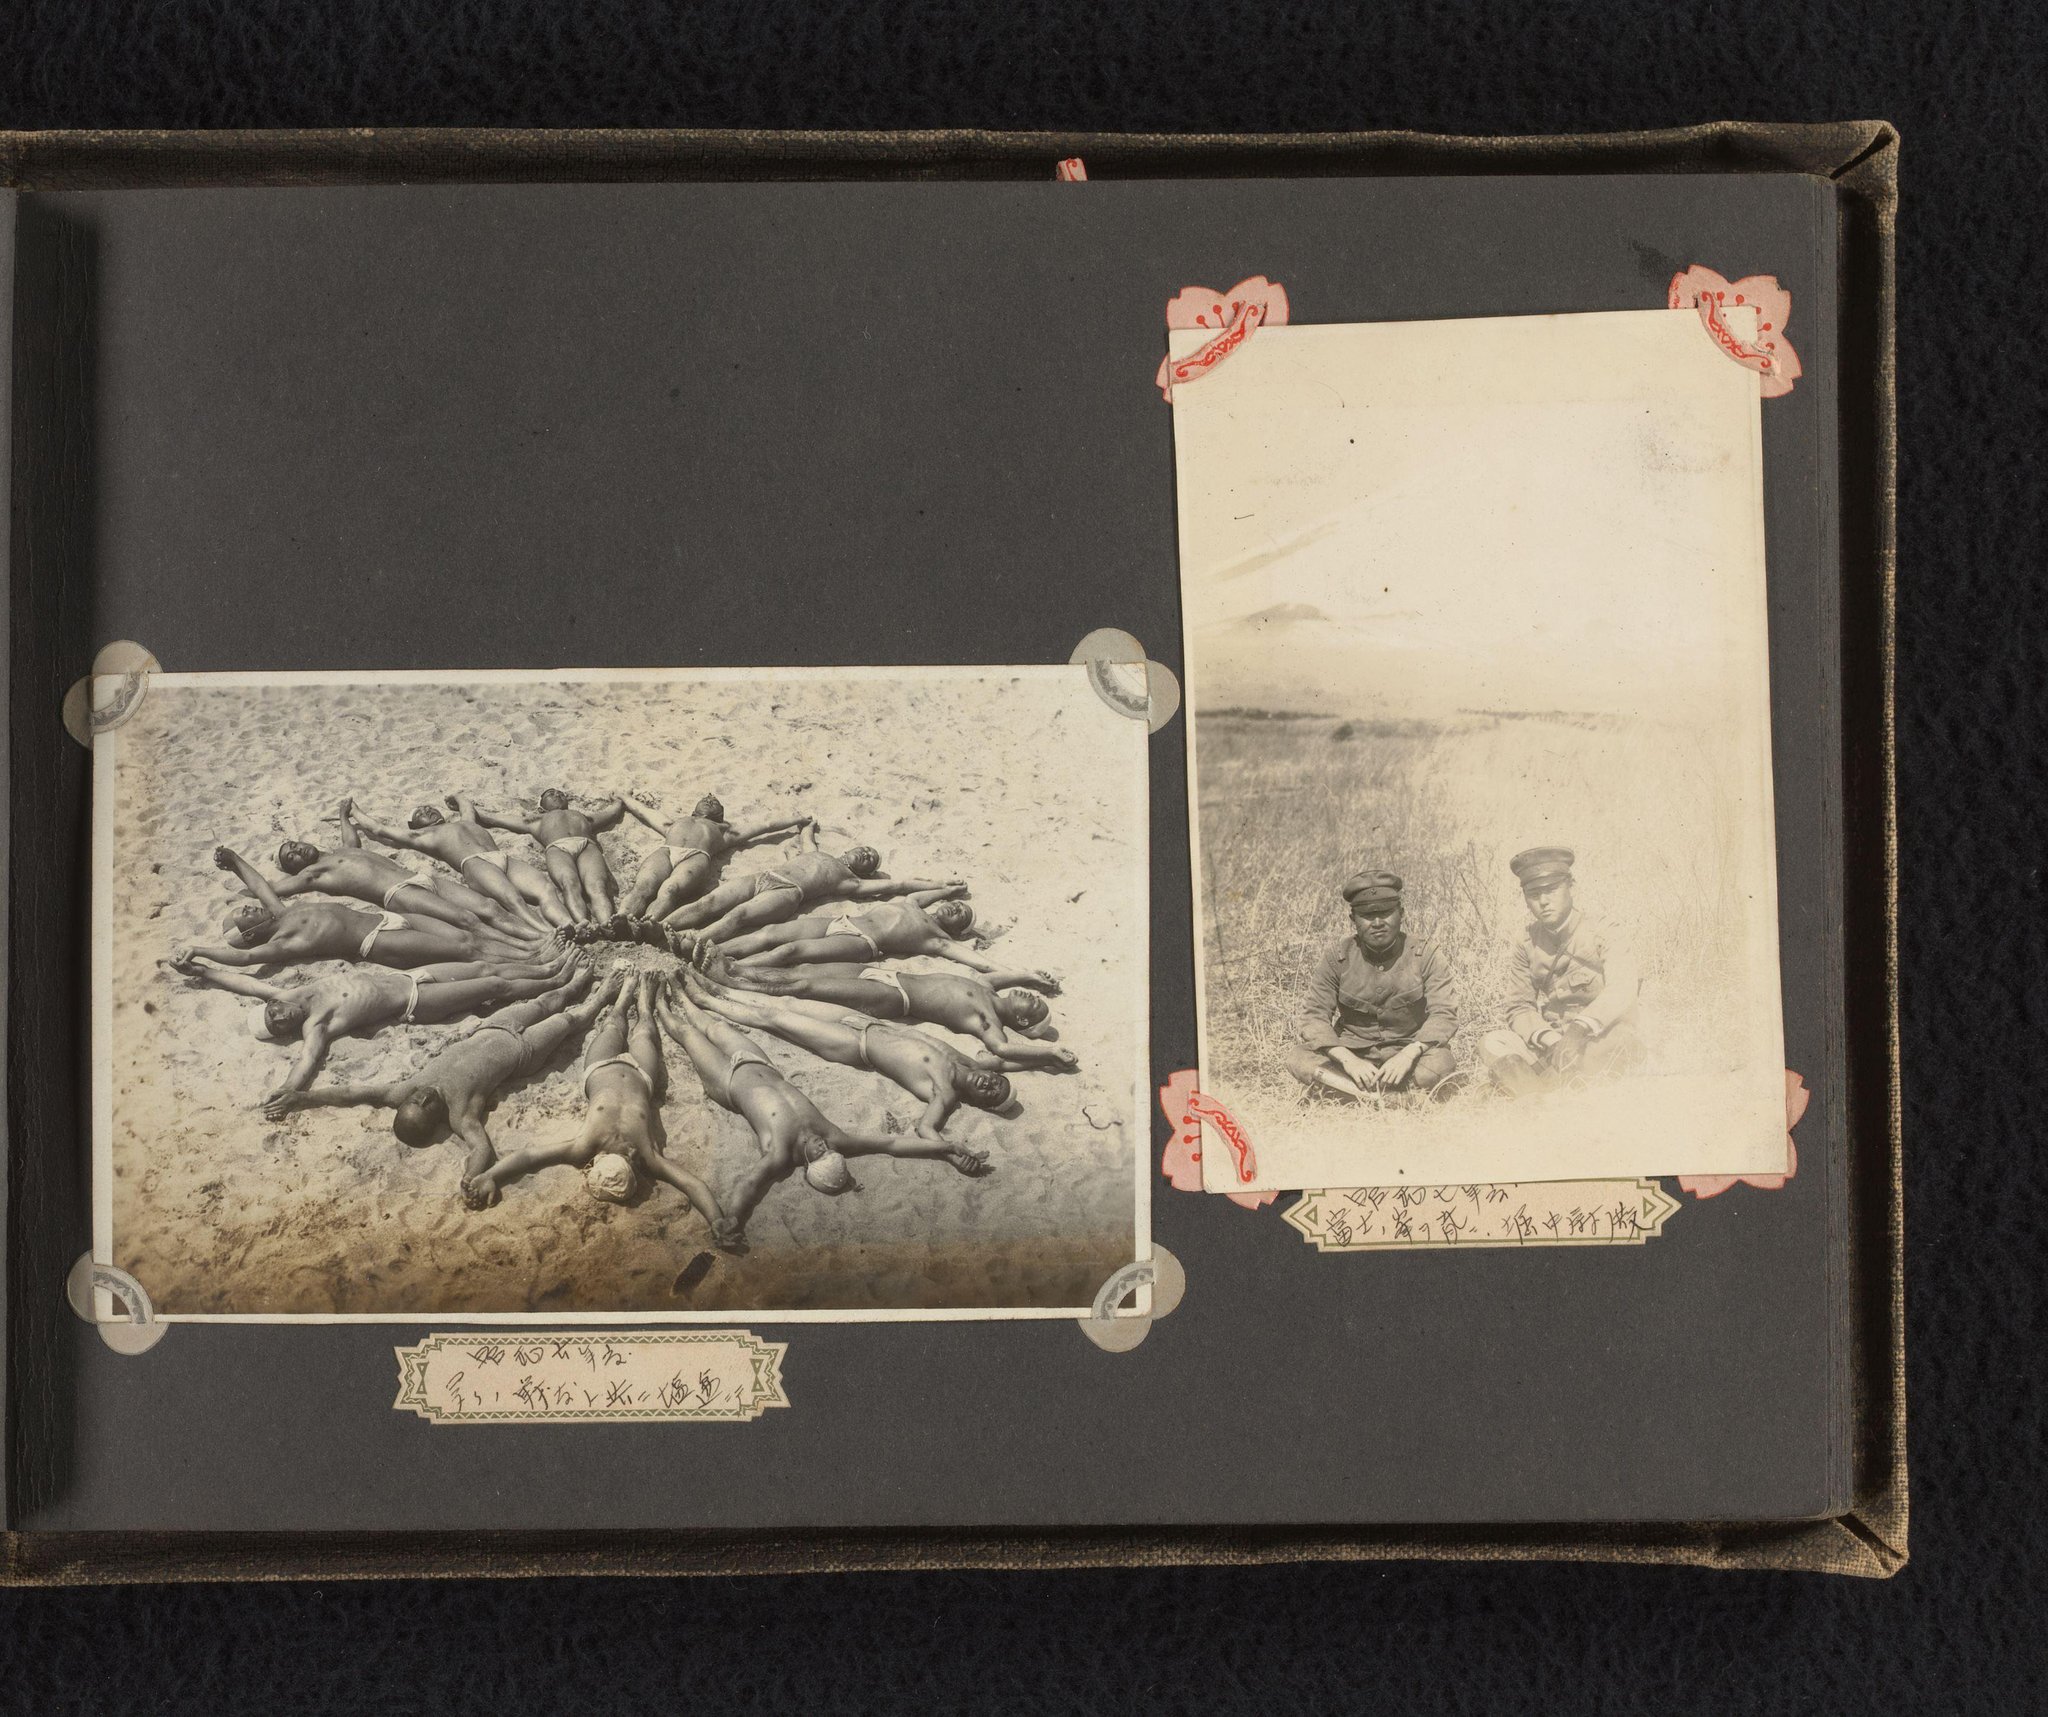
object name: album leaf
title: Japanse soldaten op het strand, links 13 mannen liggend in een cirkel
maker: Anonymous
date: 1930-1940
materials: paper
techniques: gelatin silver print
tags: the soldier; the soldier's life, beach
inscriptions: inscription: ‘[...]’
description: Deze foto's zijn onderdeel van een album.